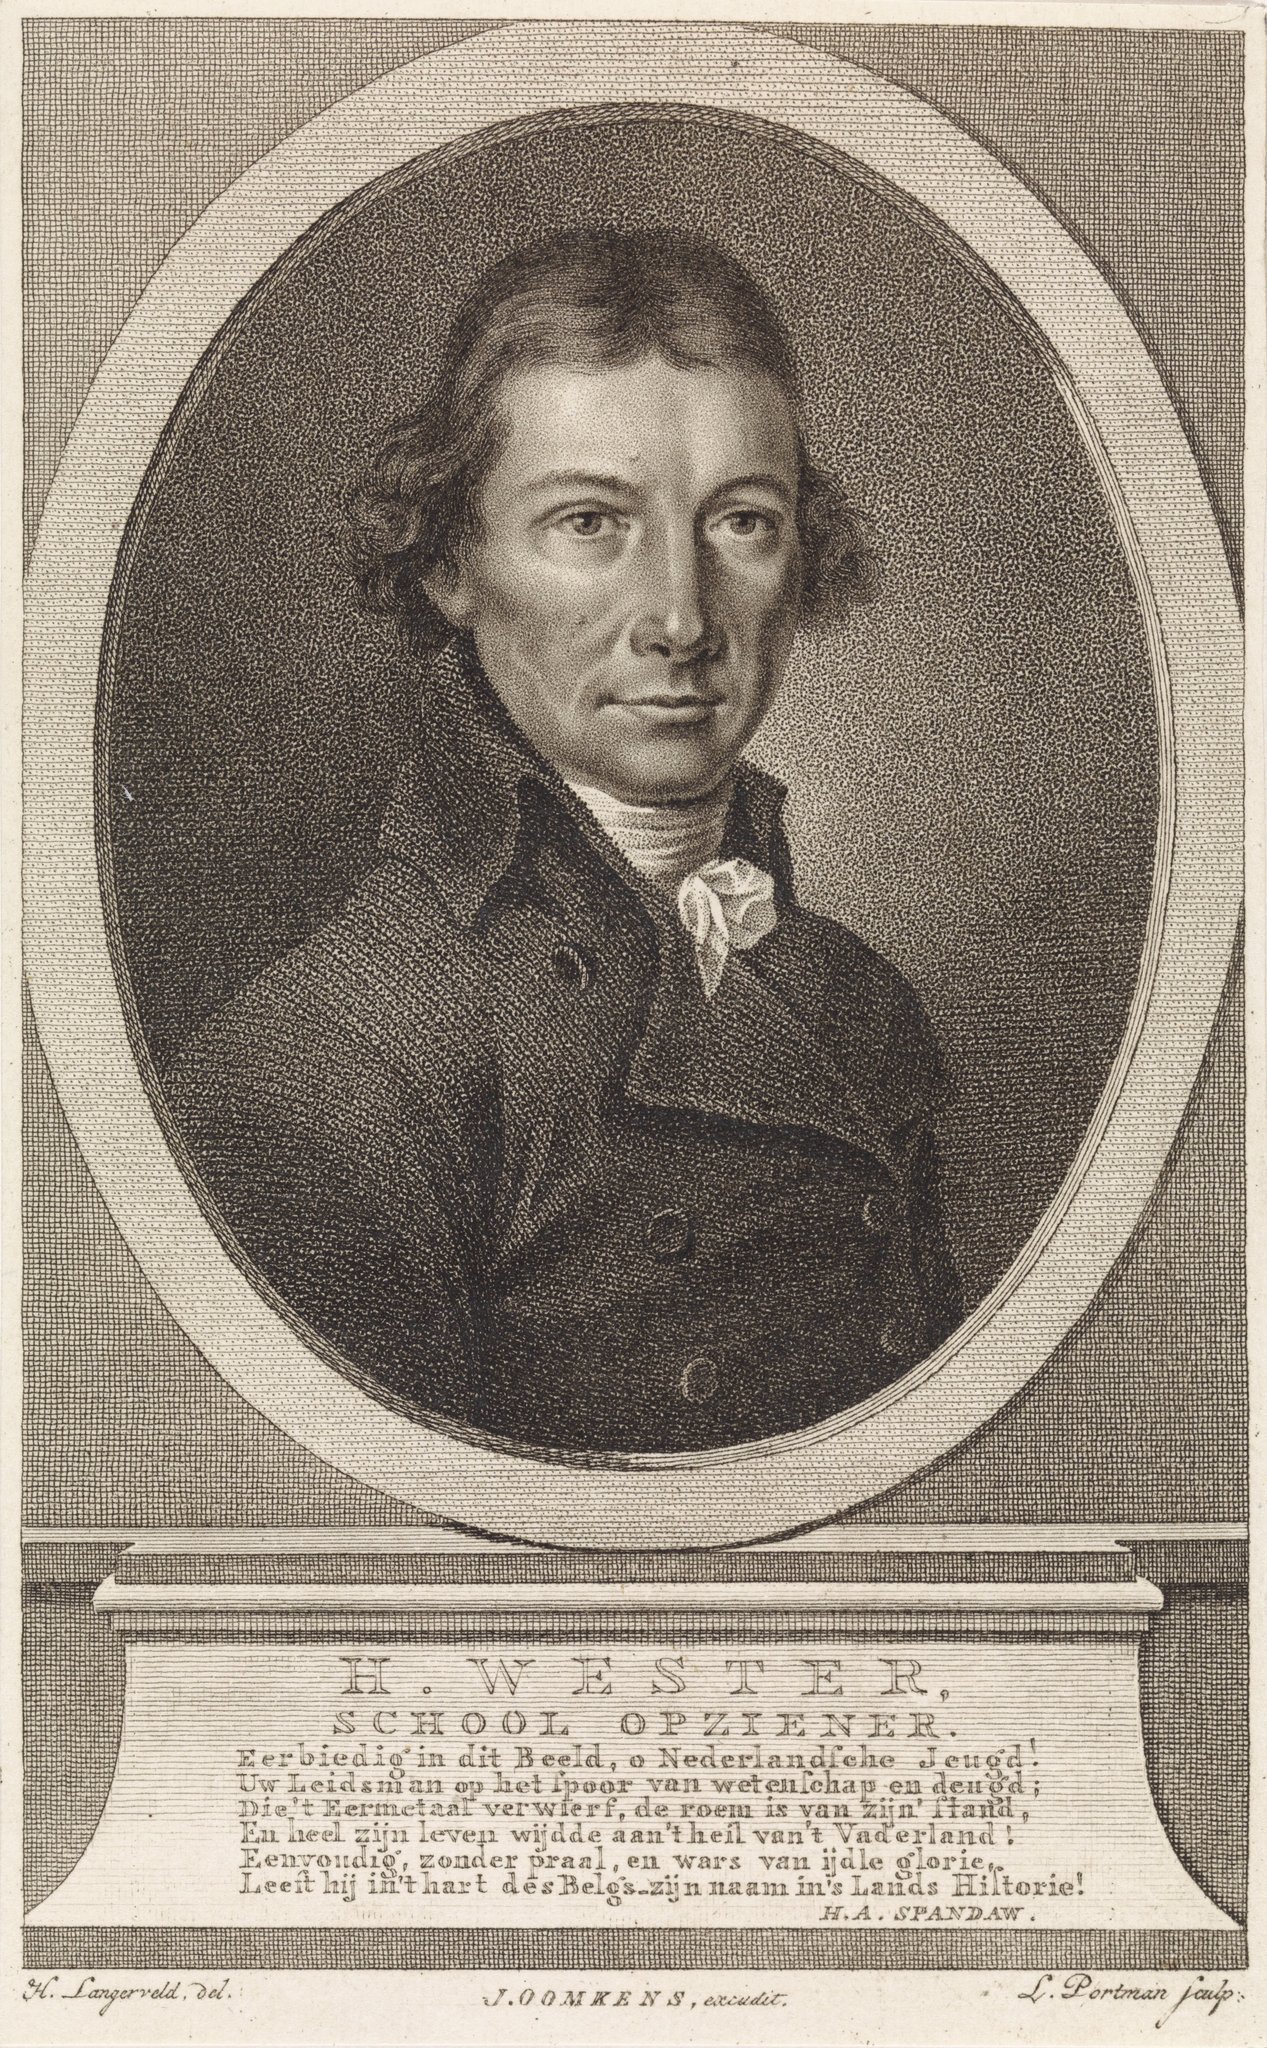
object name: print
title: Busteportret van onderwijzer Hendrik Wester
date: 1787-1844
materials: paper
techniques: etching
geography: groningen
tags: garmerwolde, oude pekela, schrijver, hendrik wester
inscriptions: collector's mark: Lugt 2228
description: Op de piëdestal een zesregelig lofdicht in het Nederlands.